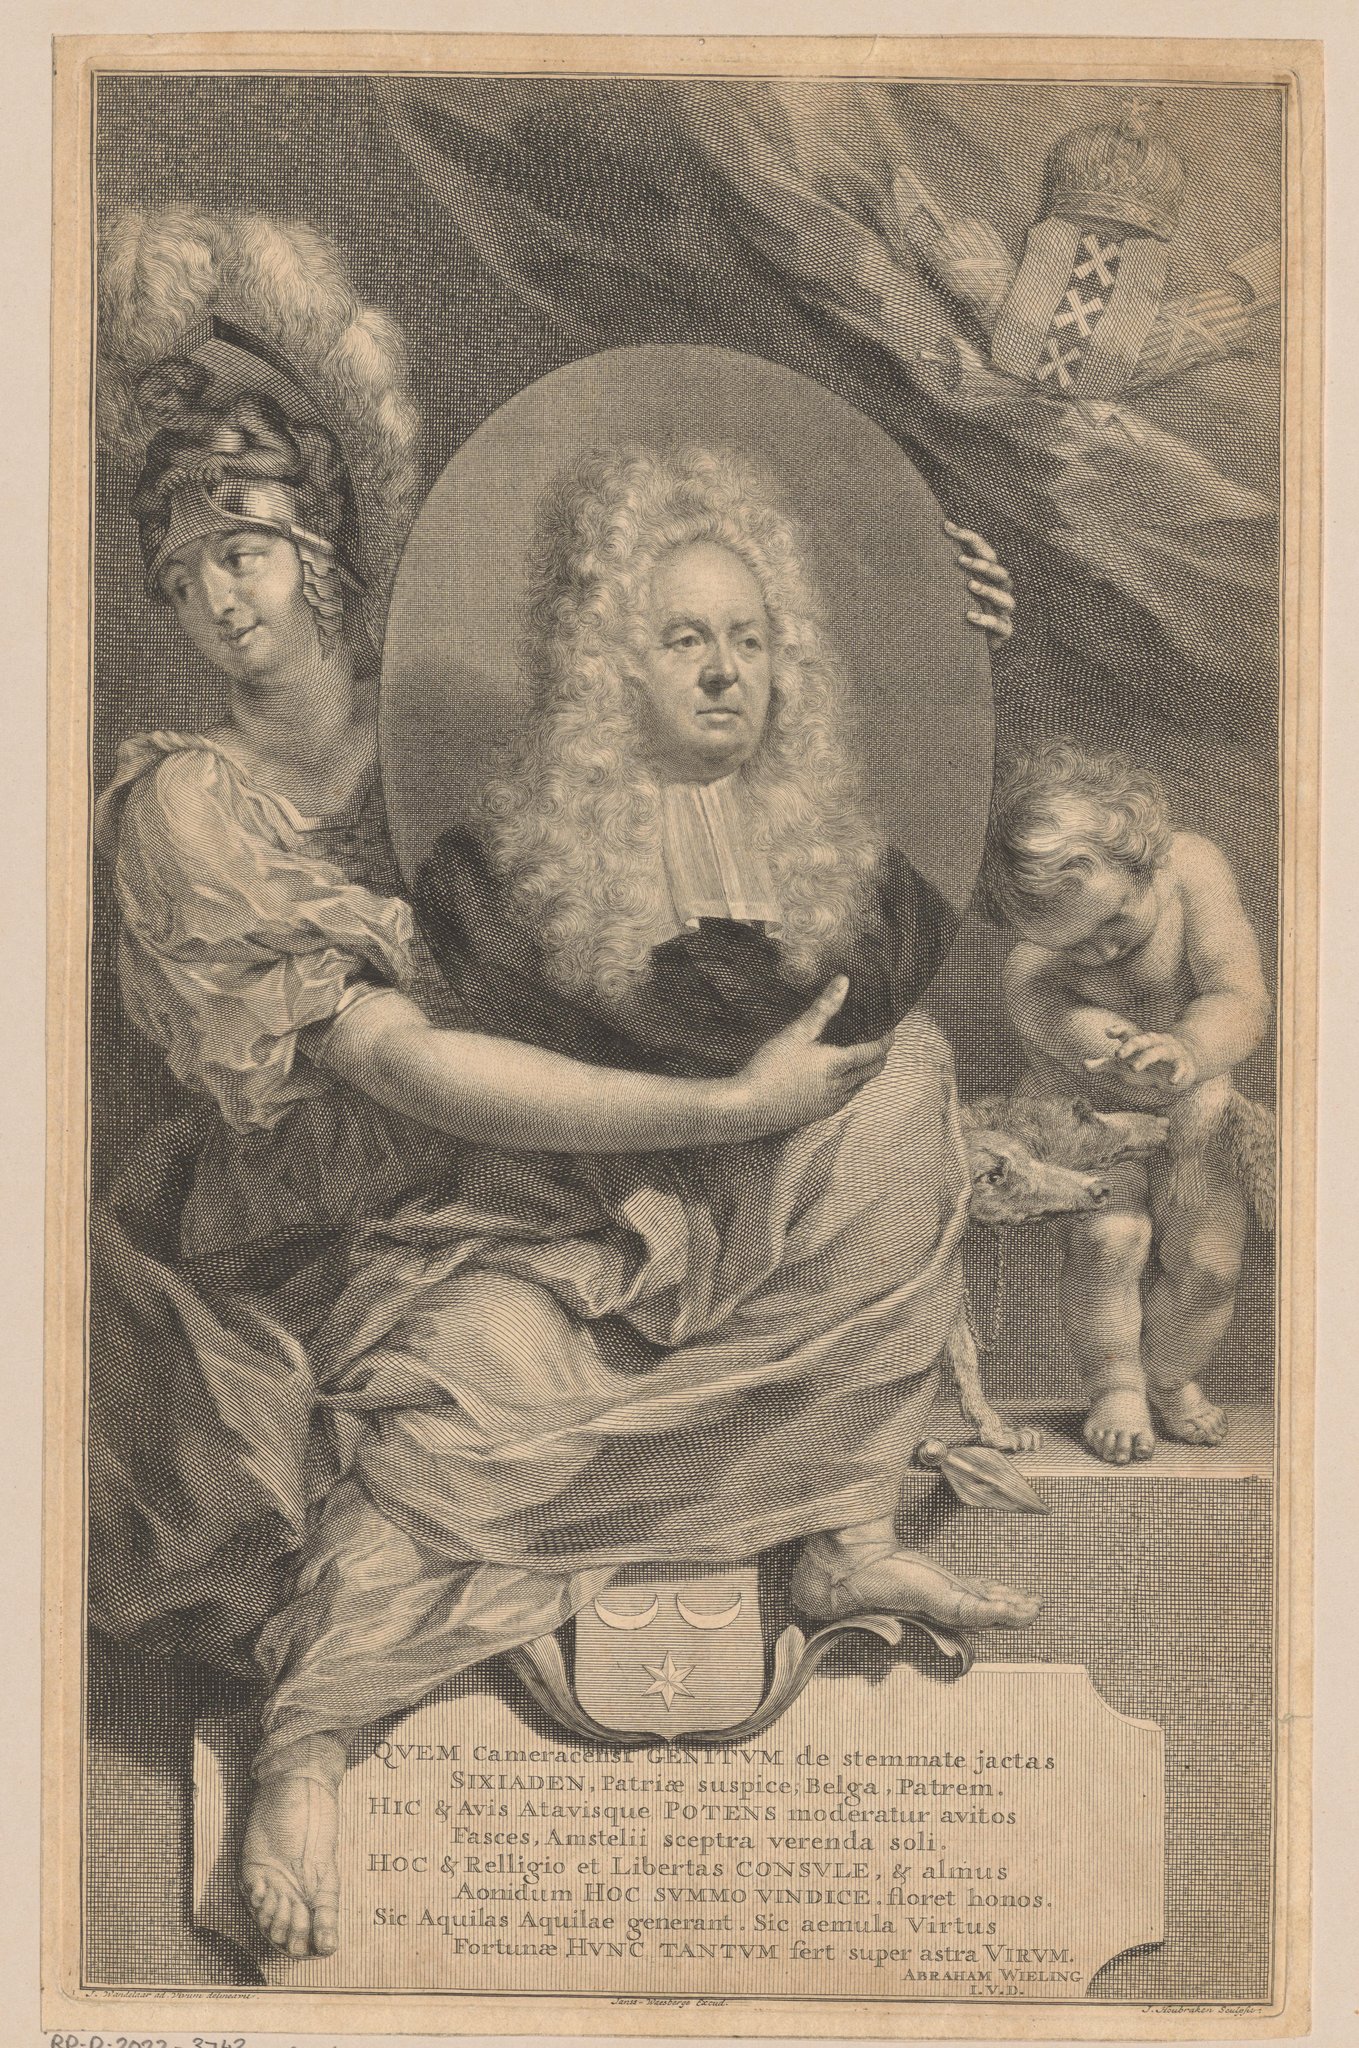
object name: print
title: Portret van Jan Six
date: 1719-1780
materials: paper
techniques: engraving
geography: amsterdam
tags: jan six (1668-1750), mayor, burgomaster, historical persons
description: Met achtregelig onderschrift in het Latijn.